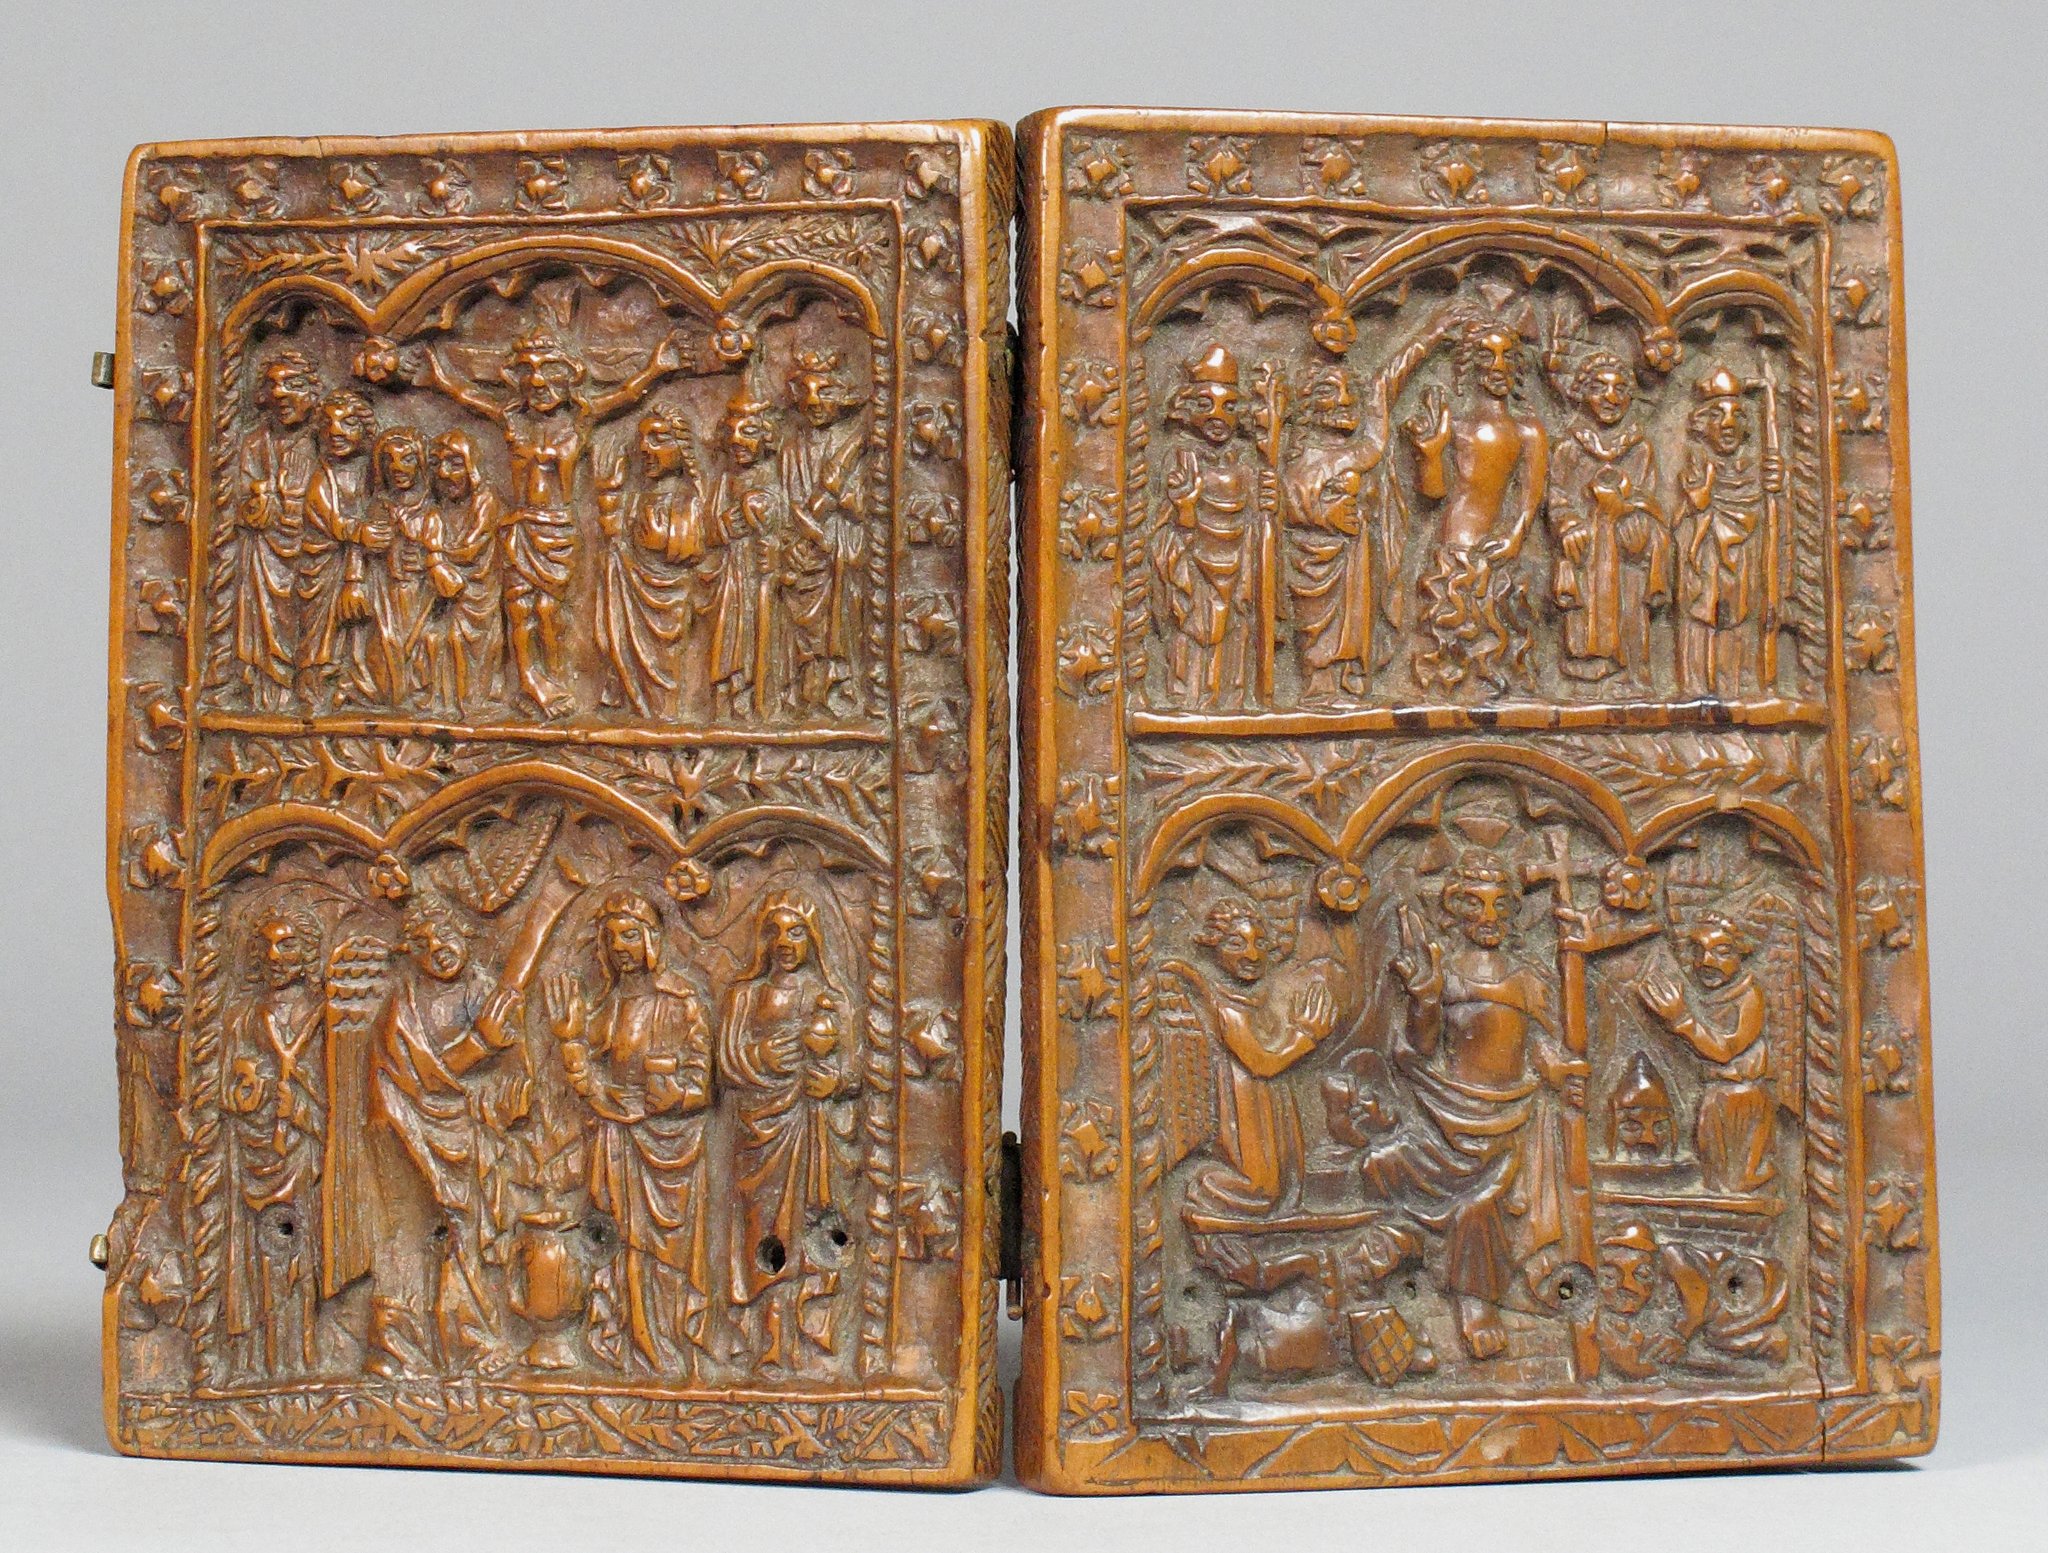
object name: writing tablet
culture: british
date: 1301-1400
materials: wood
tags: angels,christ,virgin mary,cross,annunciation,crucifixion,saints,resurrection